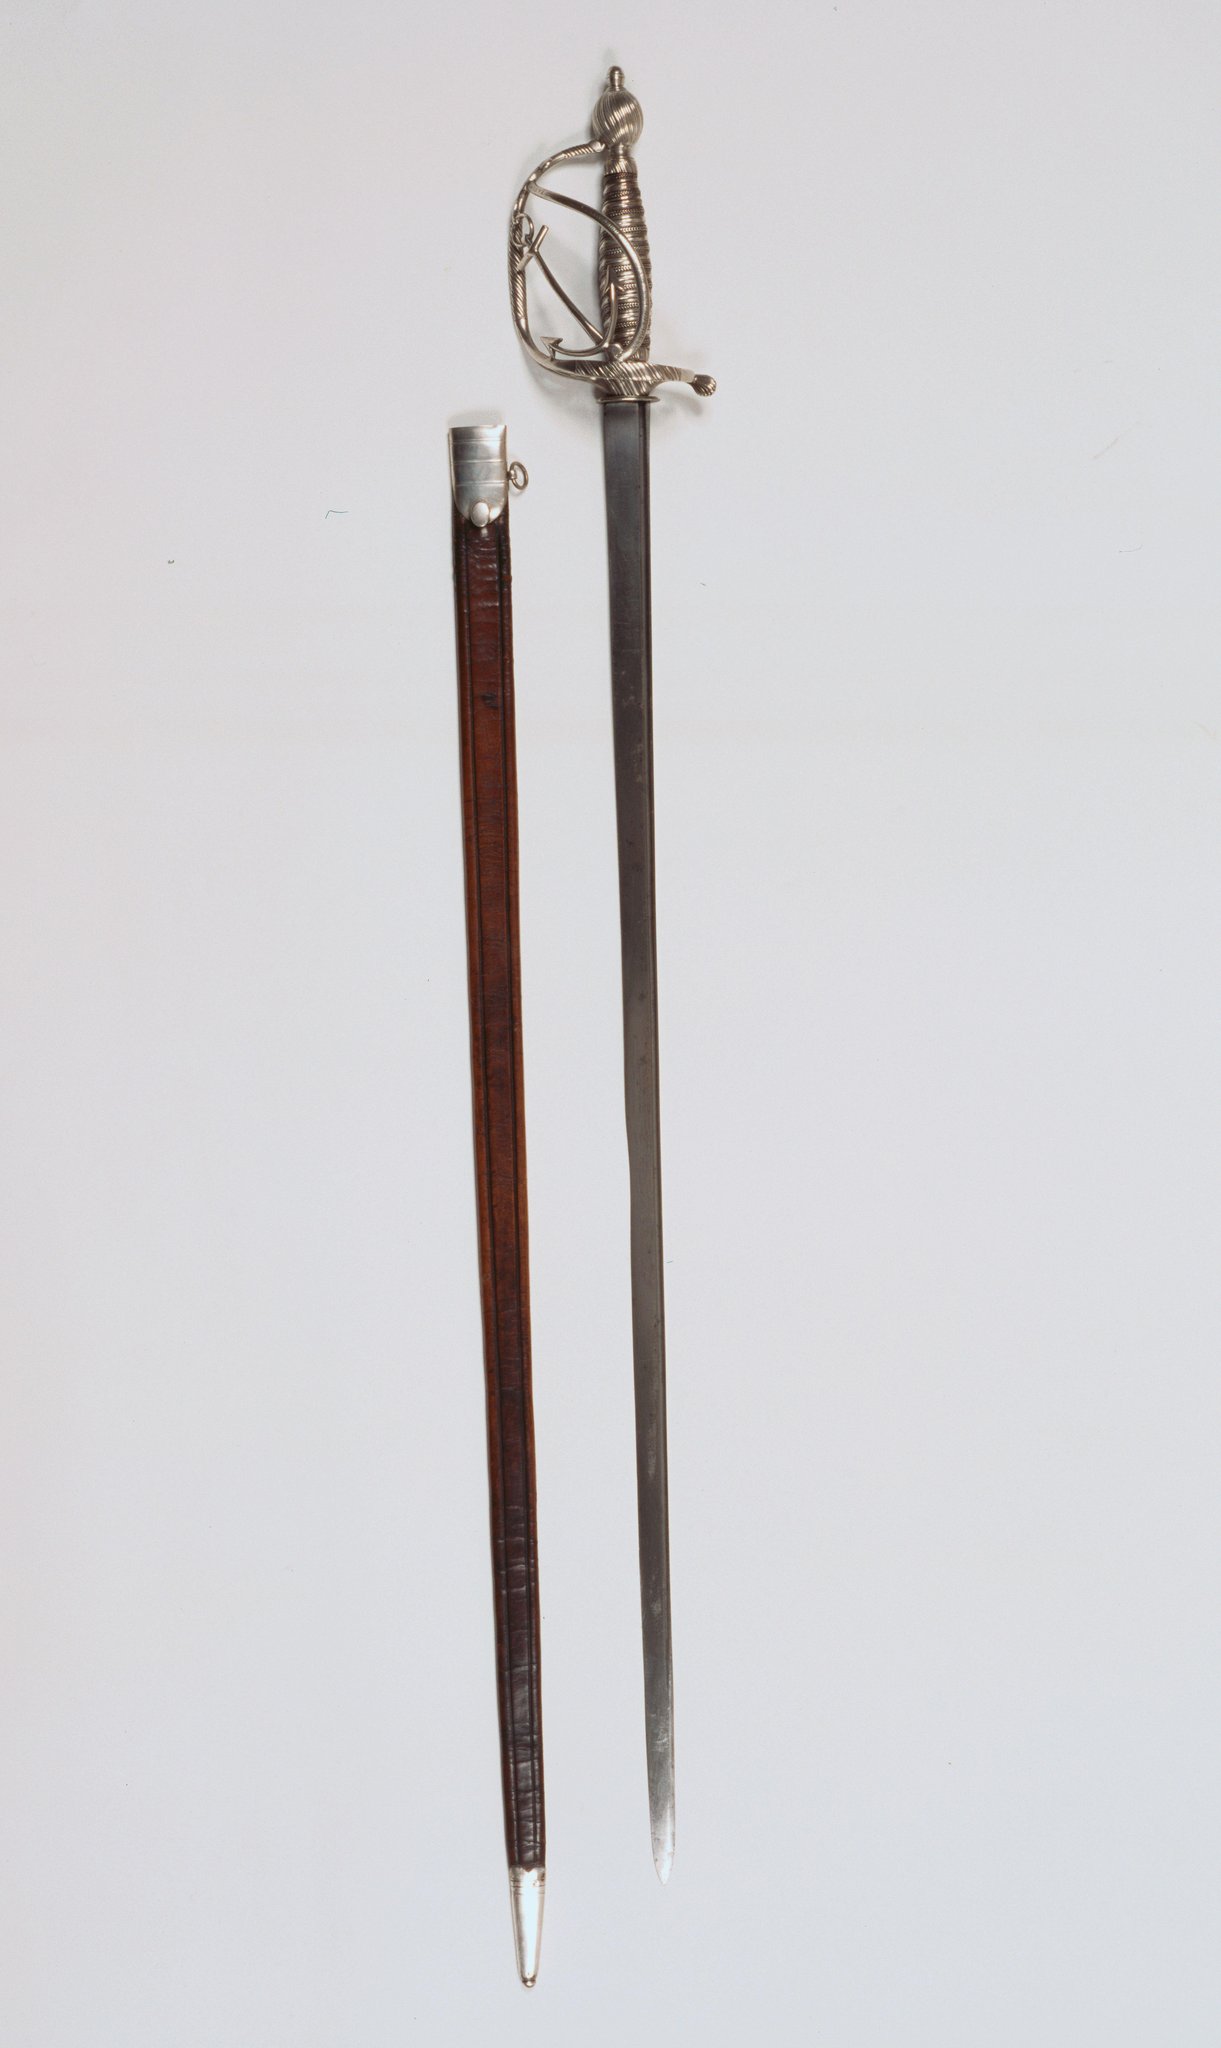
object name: sword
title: Degen met schede herinnerend aan de verovering van de St. Lucie door luitenant W. O. Bloys van Treslong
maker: Anonymous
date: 1800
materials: iron, leather, silver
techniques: engraving, forging, sewing, striking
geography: amsterdam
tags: commandant, willem otto bloys van treslong, lillo, eerste coalitie-oorlog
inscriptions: : ‘AANDENKE VOOR DE VEROVERING DER FRANSE CANNON: BRIK LA ST. LUCIE VOOR LILLO OP DEN 20 MAART 1793’